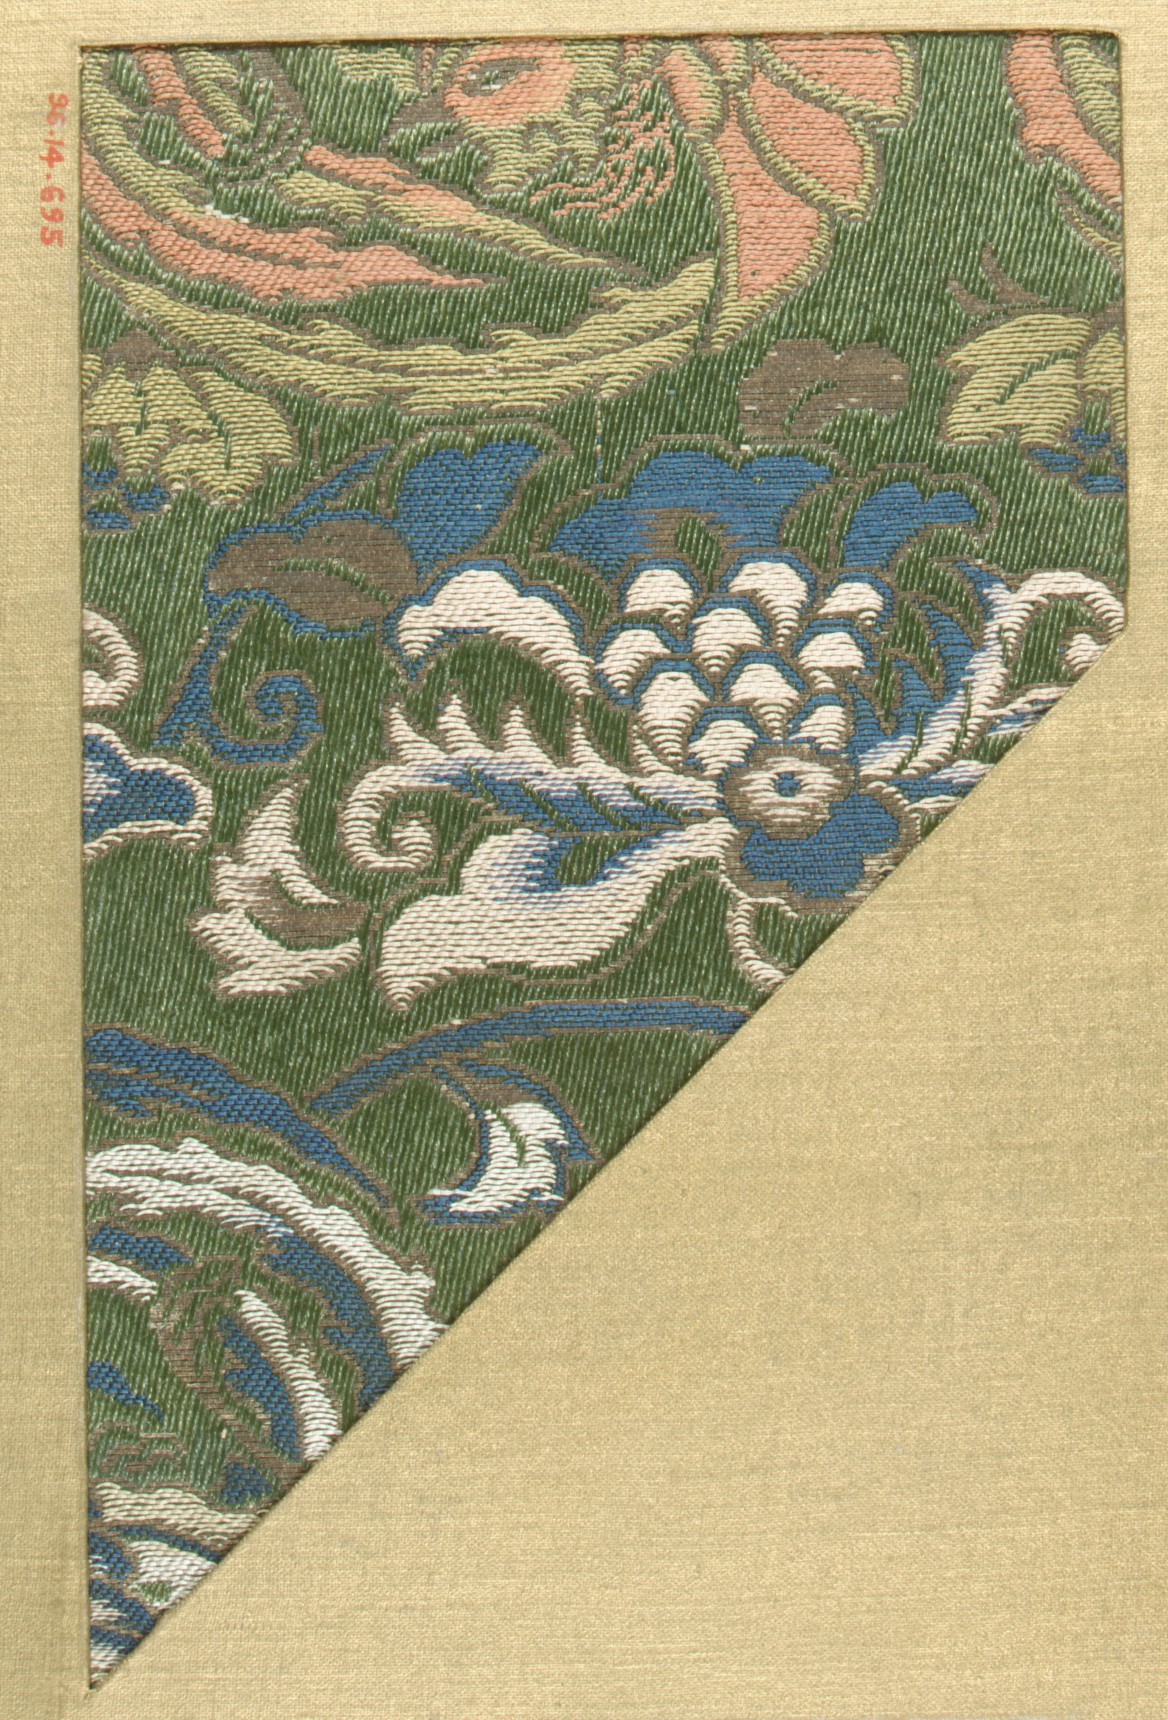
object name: piece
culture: japanese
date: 1701-1900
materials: silk